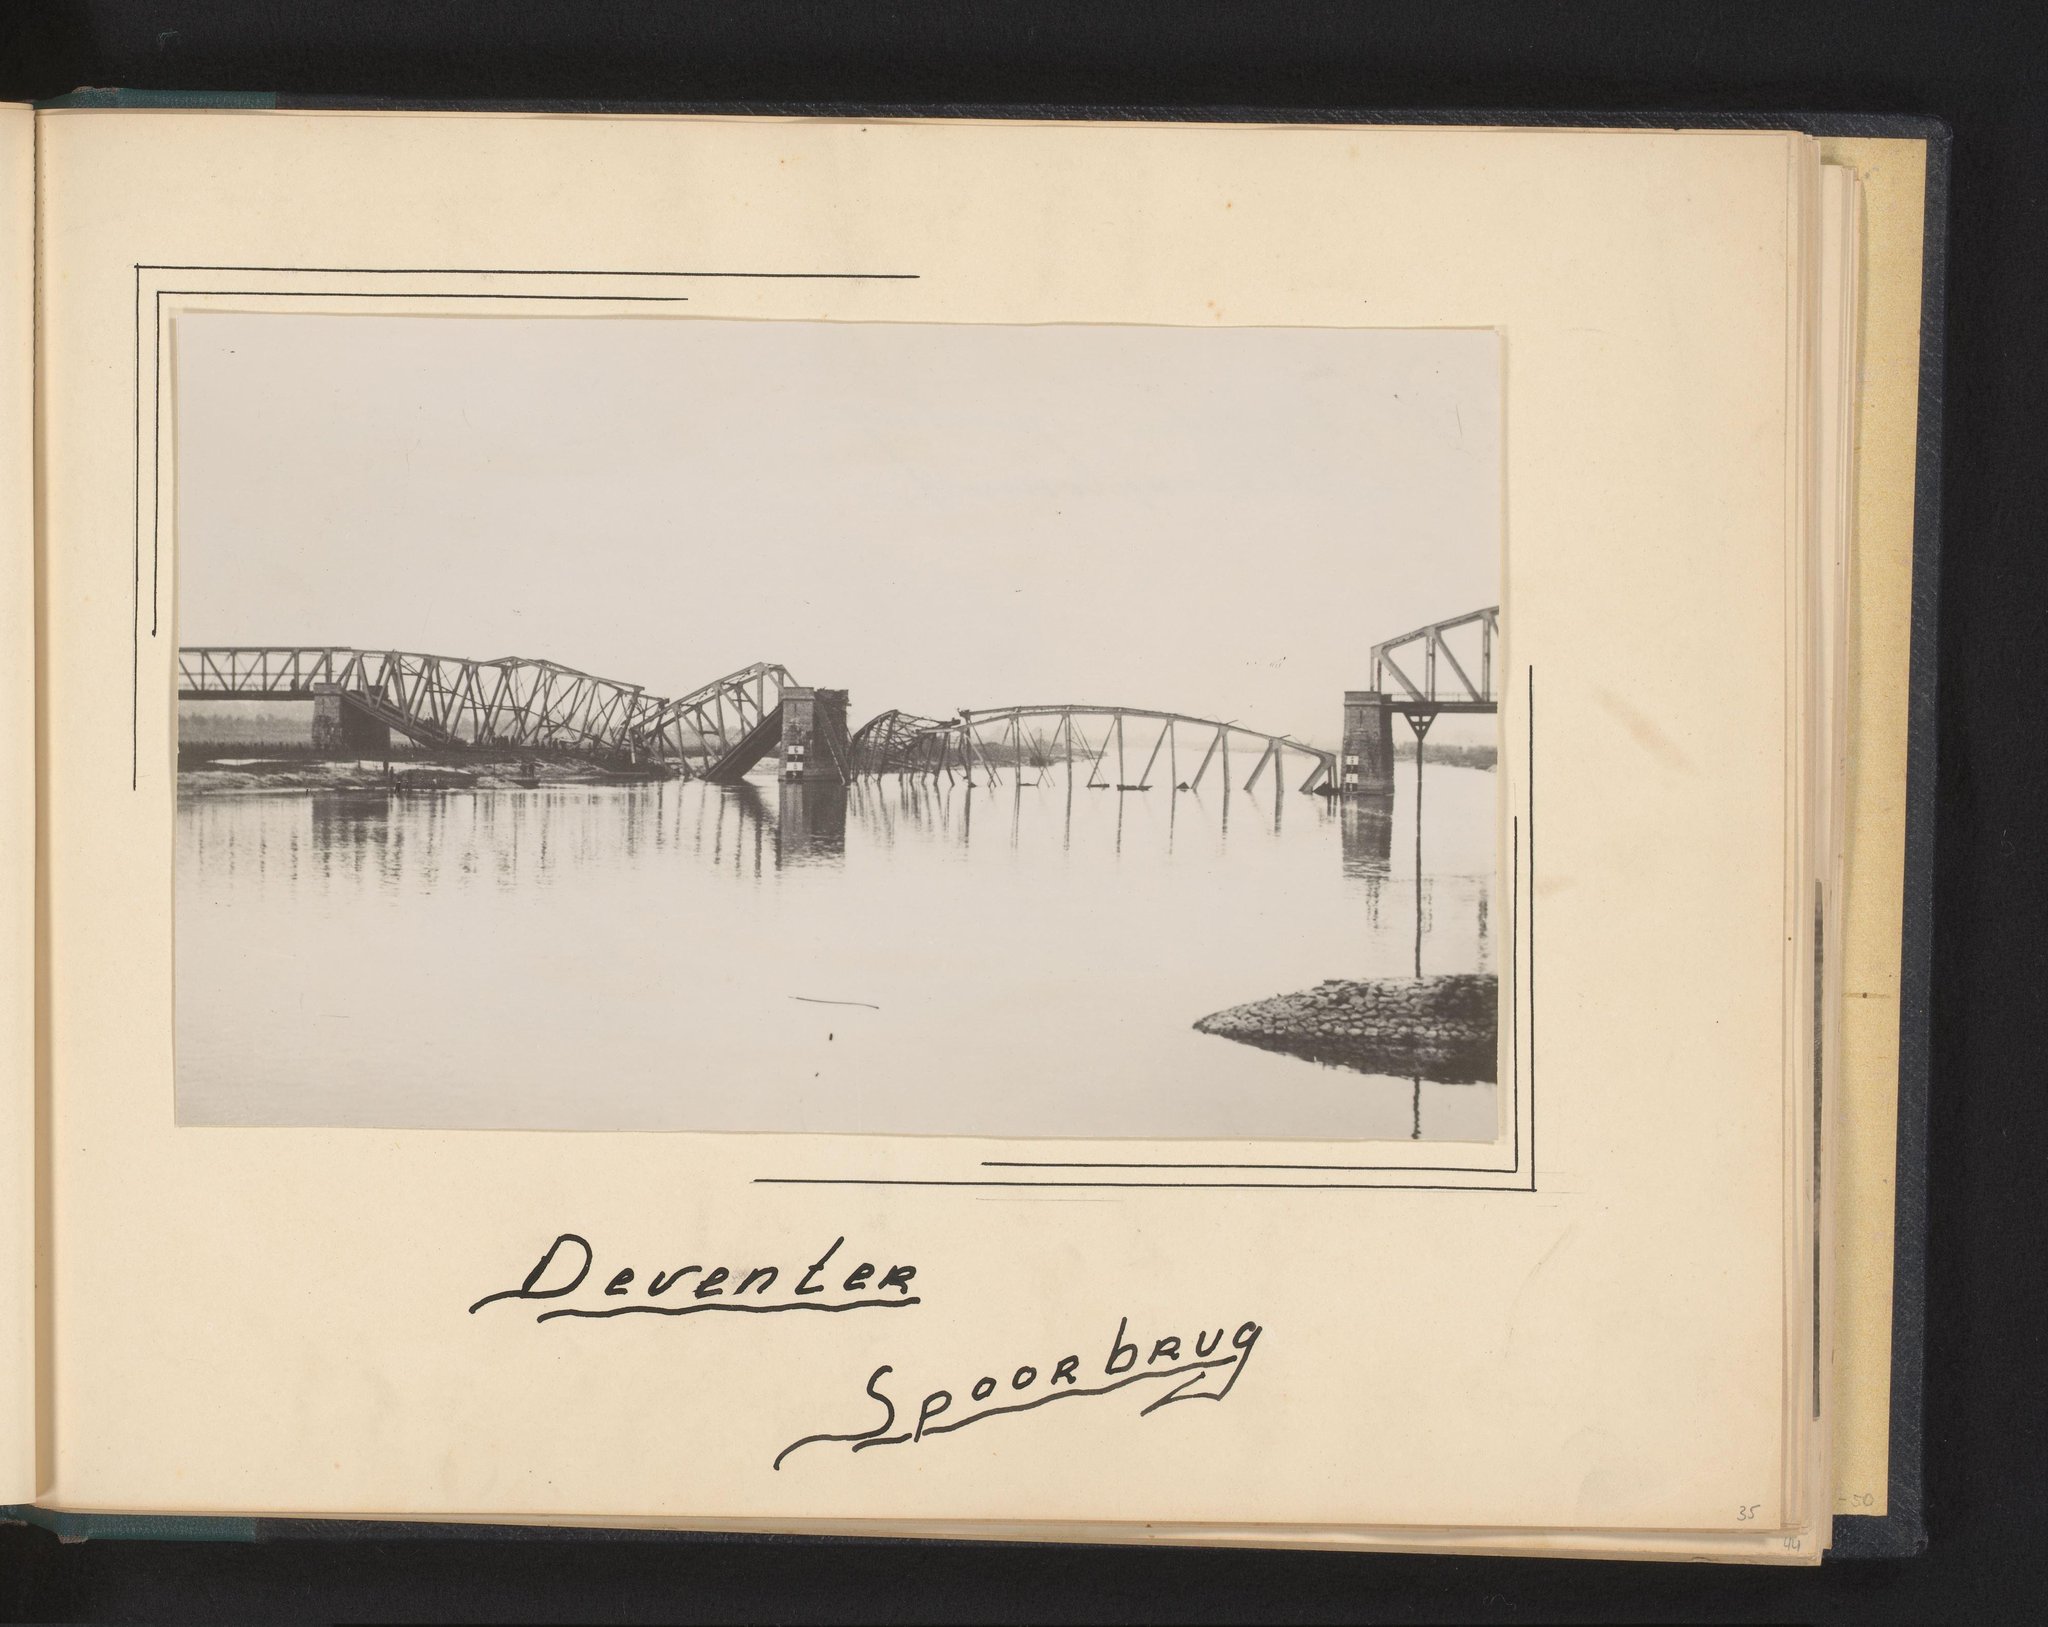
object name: album leaf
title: Deventer Spoorbrug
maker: arnoldus vrauwdêunt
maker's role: graficus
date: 1940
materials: cardboard, paper, photographic support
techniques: gelatin silver print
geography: deventer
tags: obstructions, barricades (defensive measures), railway, tramway; rack railway, bridge, netherlands, deventer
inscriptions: inscription: ‘Deventer Spoorbrug’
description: Albumblad met een foto van de opgeblazen spoorbrug bij Deventer op 10 mei 1940, in een poging om de opmars van het Duitse leger te bemoeilijken. Onderdeel van het fotoalbum over de verwoestingen van Nederlandse steden en infrastructuur in het begin van de Tweede Wereldoorlog.